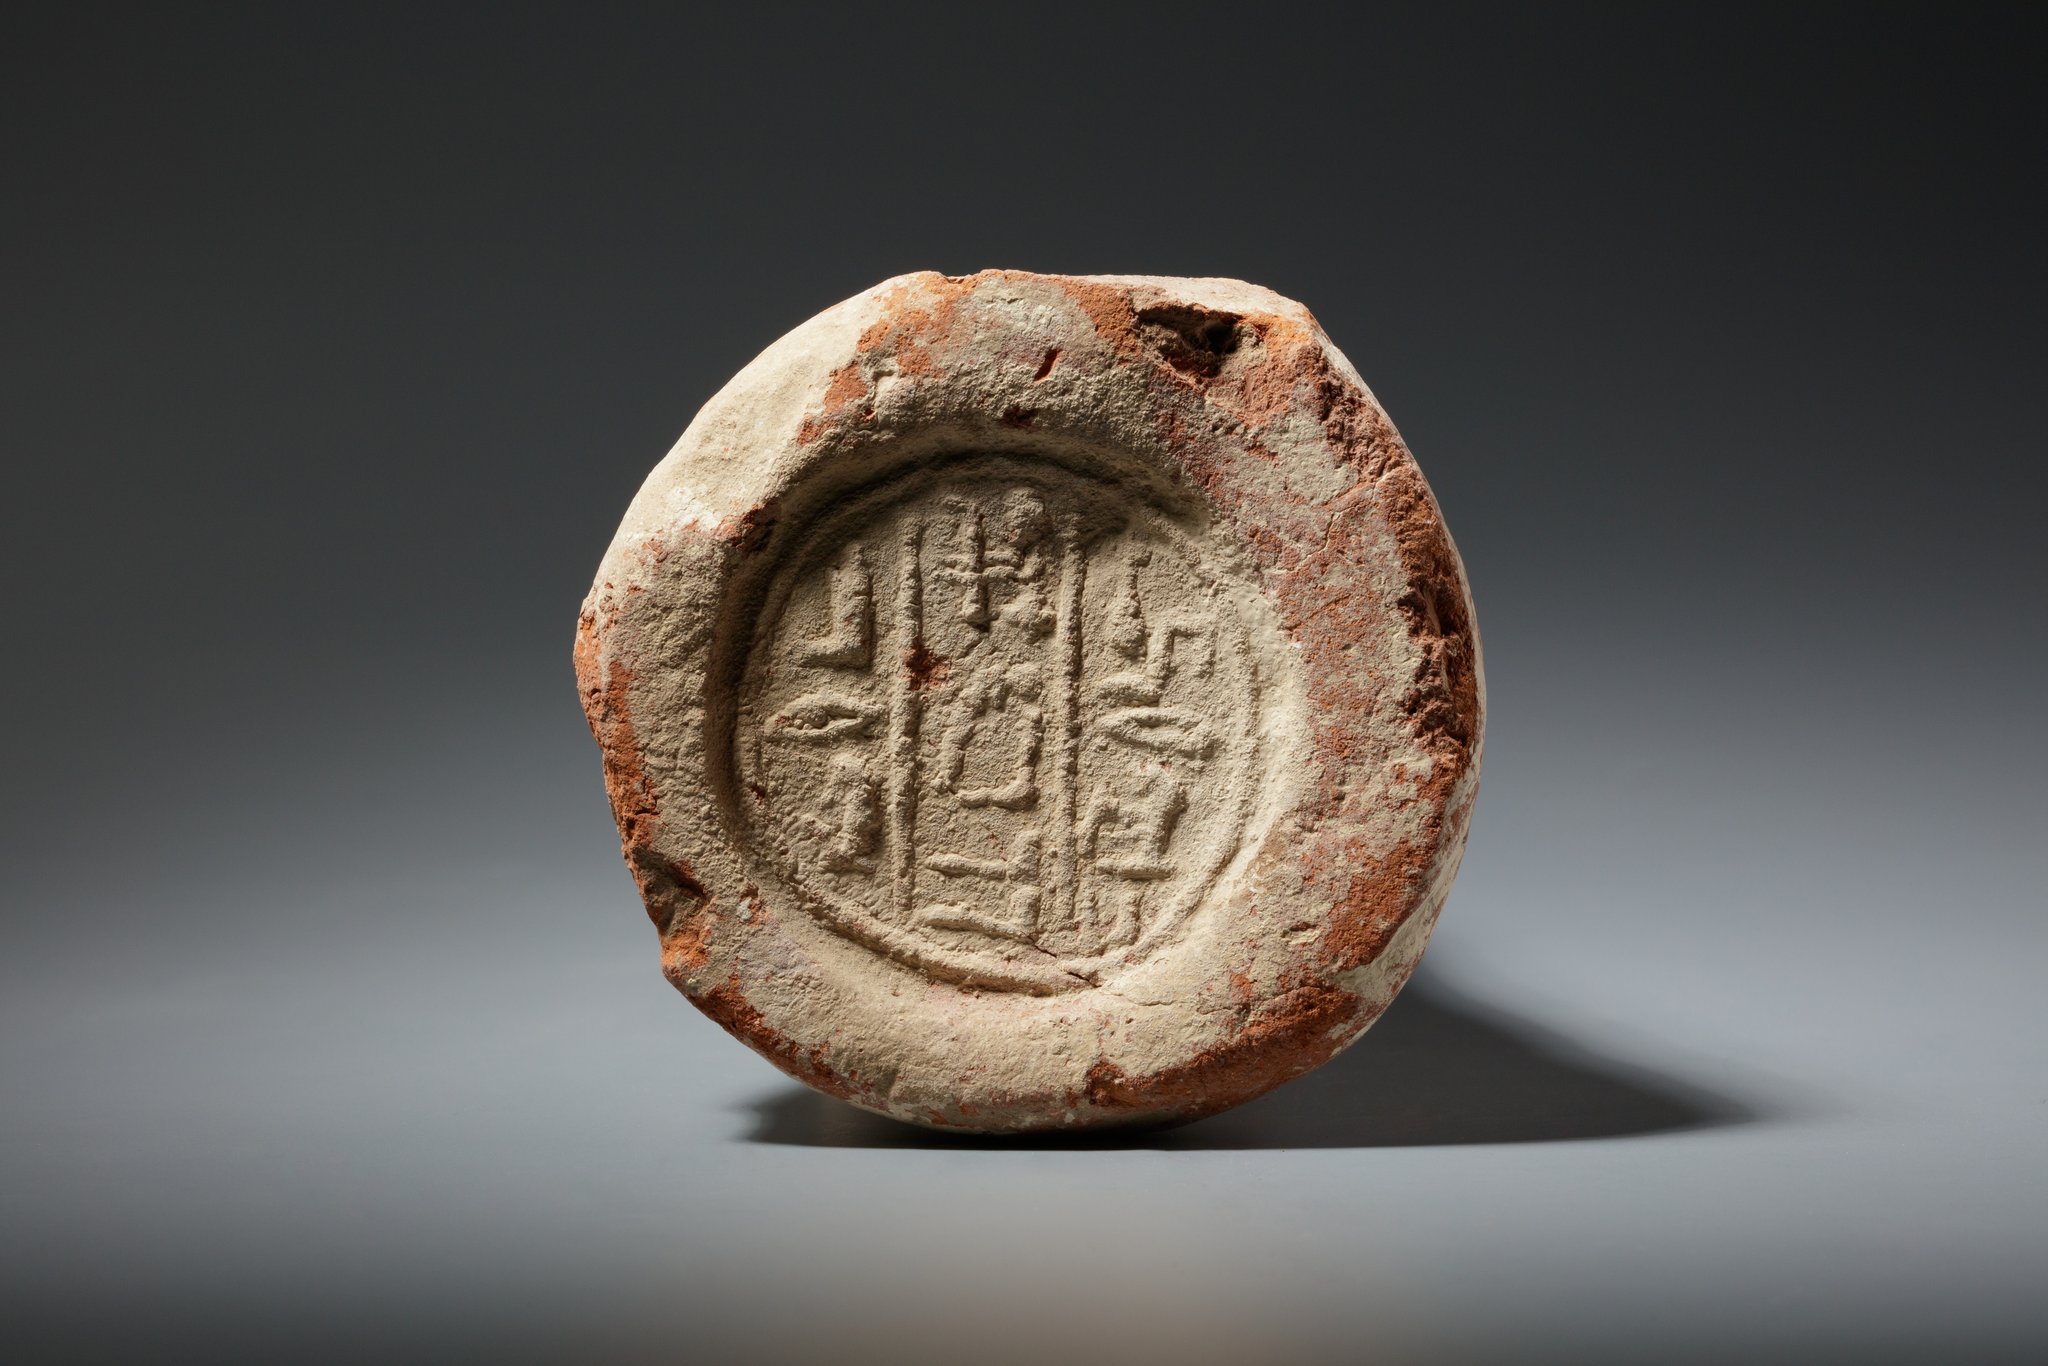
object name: cone, davy 213, neferperet, cup bearer, king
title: Funerary Cone the Cup-Bearer Neferperet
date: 1550-1295 BCE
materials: pottery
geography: egypt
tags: hieroglyphs